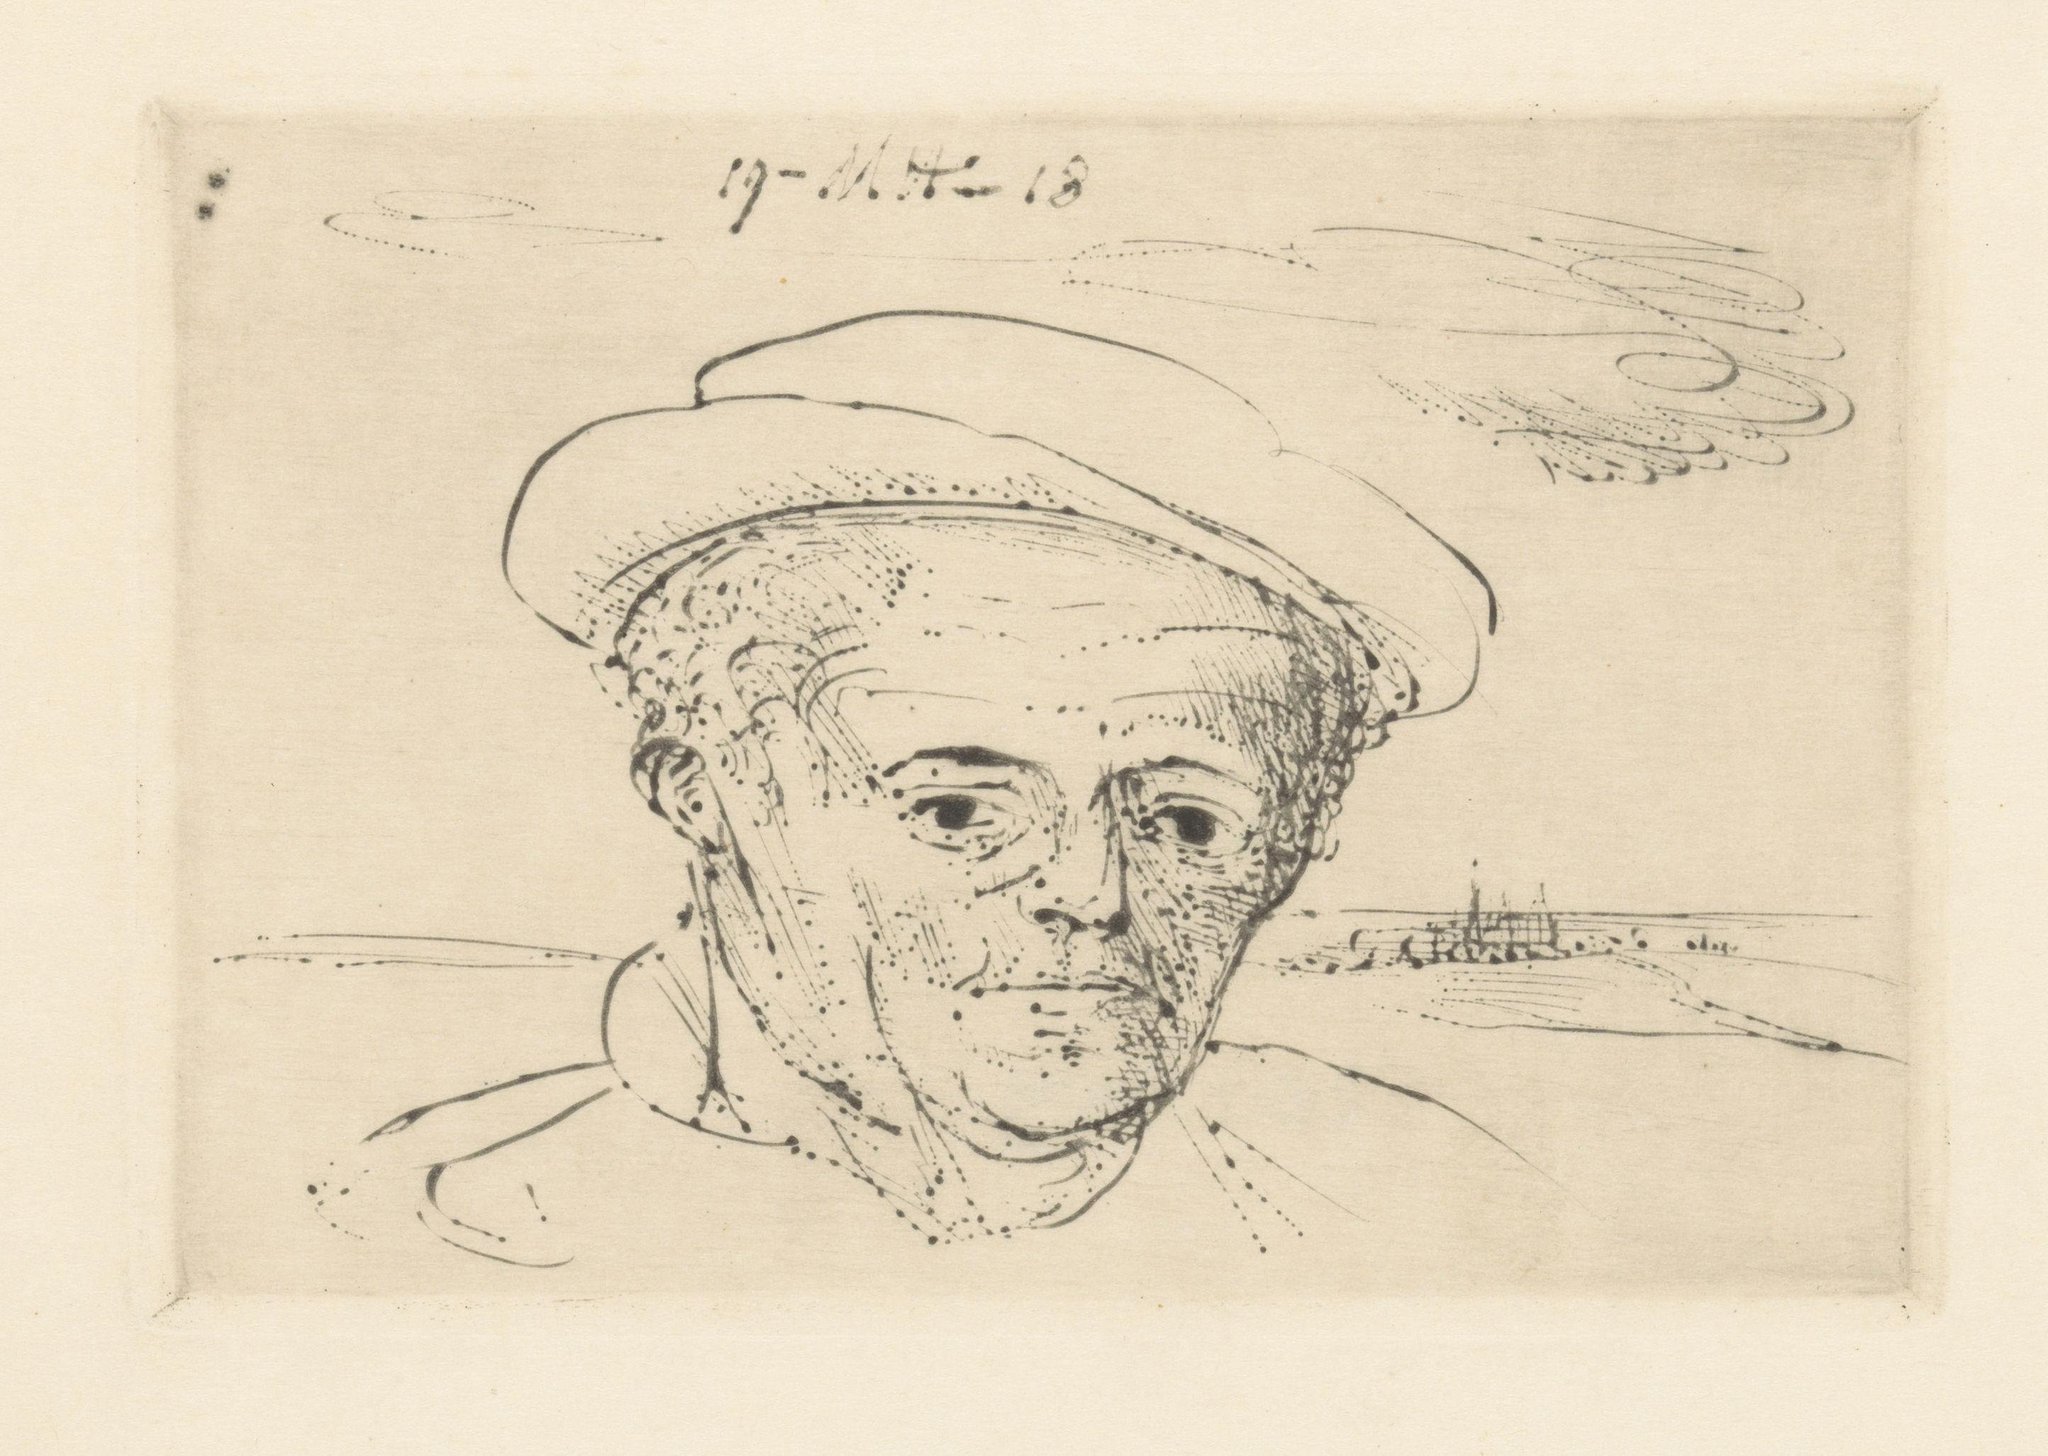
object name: print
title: Man met baret in landschap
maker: marius holleman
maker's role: draughtsman, print maker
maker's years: 1878-1926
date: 1918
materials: paper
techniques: etching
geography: groningen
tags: landscapes in the temperate zone, head-gear: beret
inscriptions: collector's mark: Lugt 2228